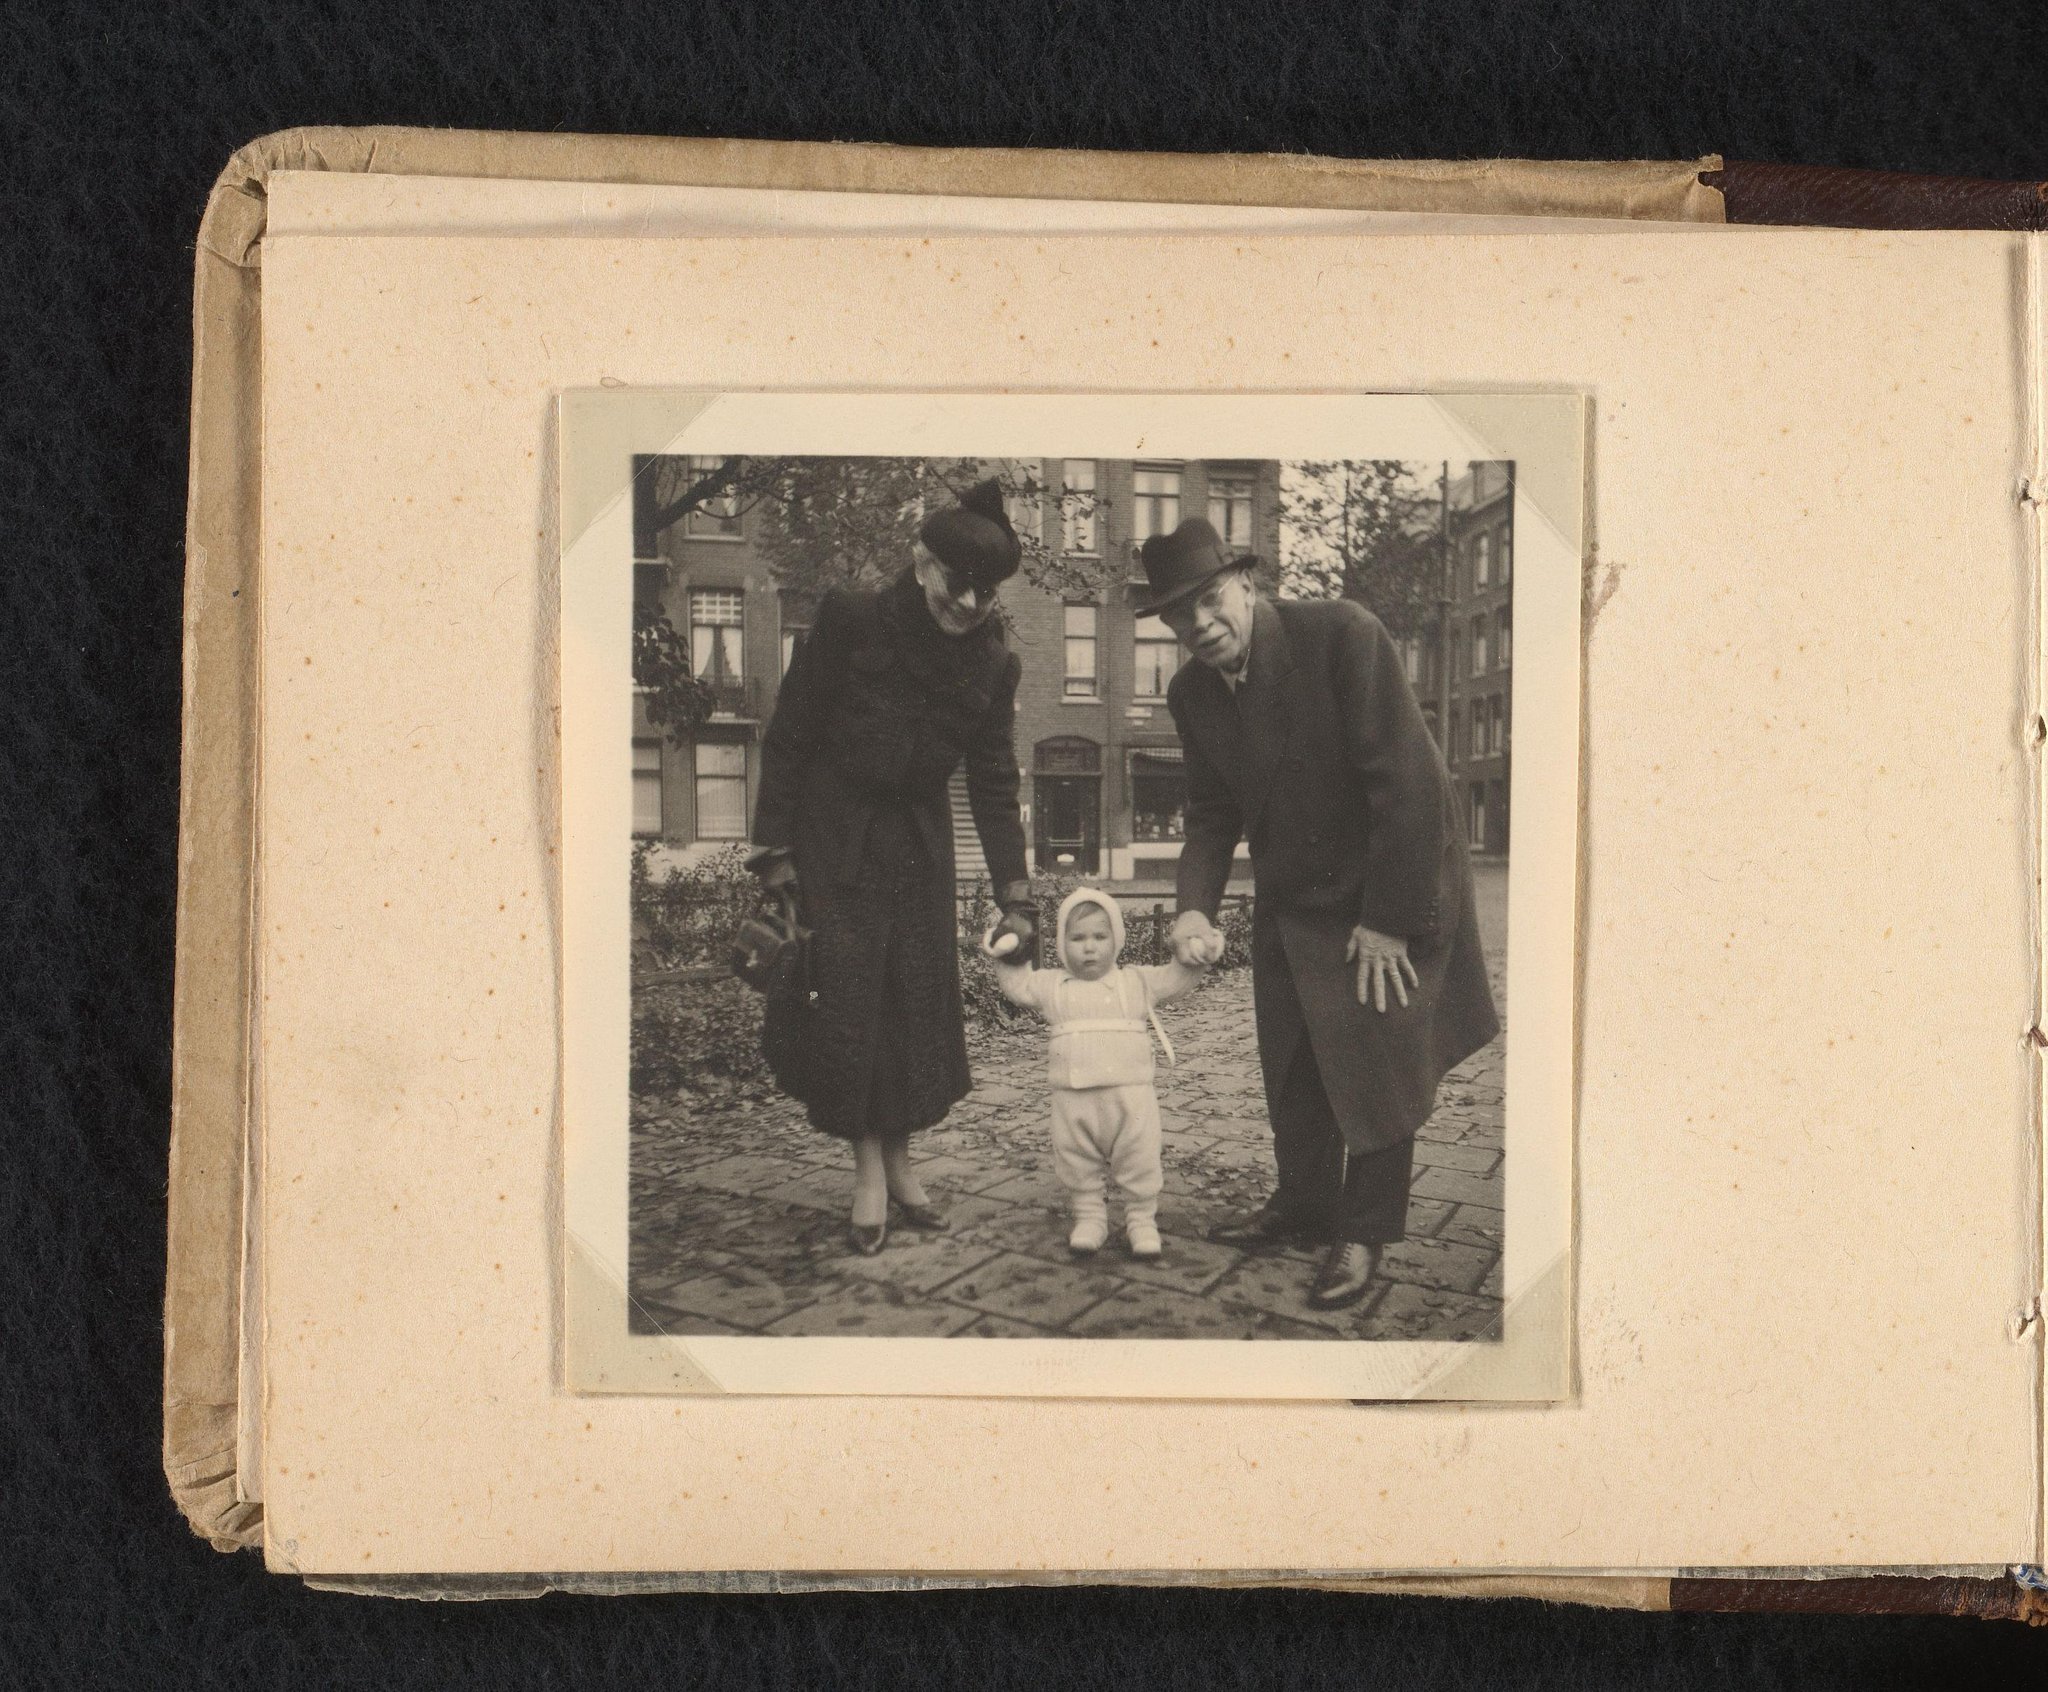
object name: album leaf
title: Hendrik Hermanen en Caroline Louise van den Berg hand-in-hand met kleinzoon Norbert Peter van den Berg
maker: norbert peter van den berg (1941-)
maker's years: 1941-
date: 1944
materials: paper, cardboard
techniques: gelatin silver print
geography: netherlands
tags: batavia, amsterdam, hendrik herman van den berg, norbert peter van den berg (1941-), the hague, caroline louise van den berg-van den berg, adult woman, adult man, infant, baby